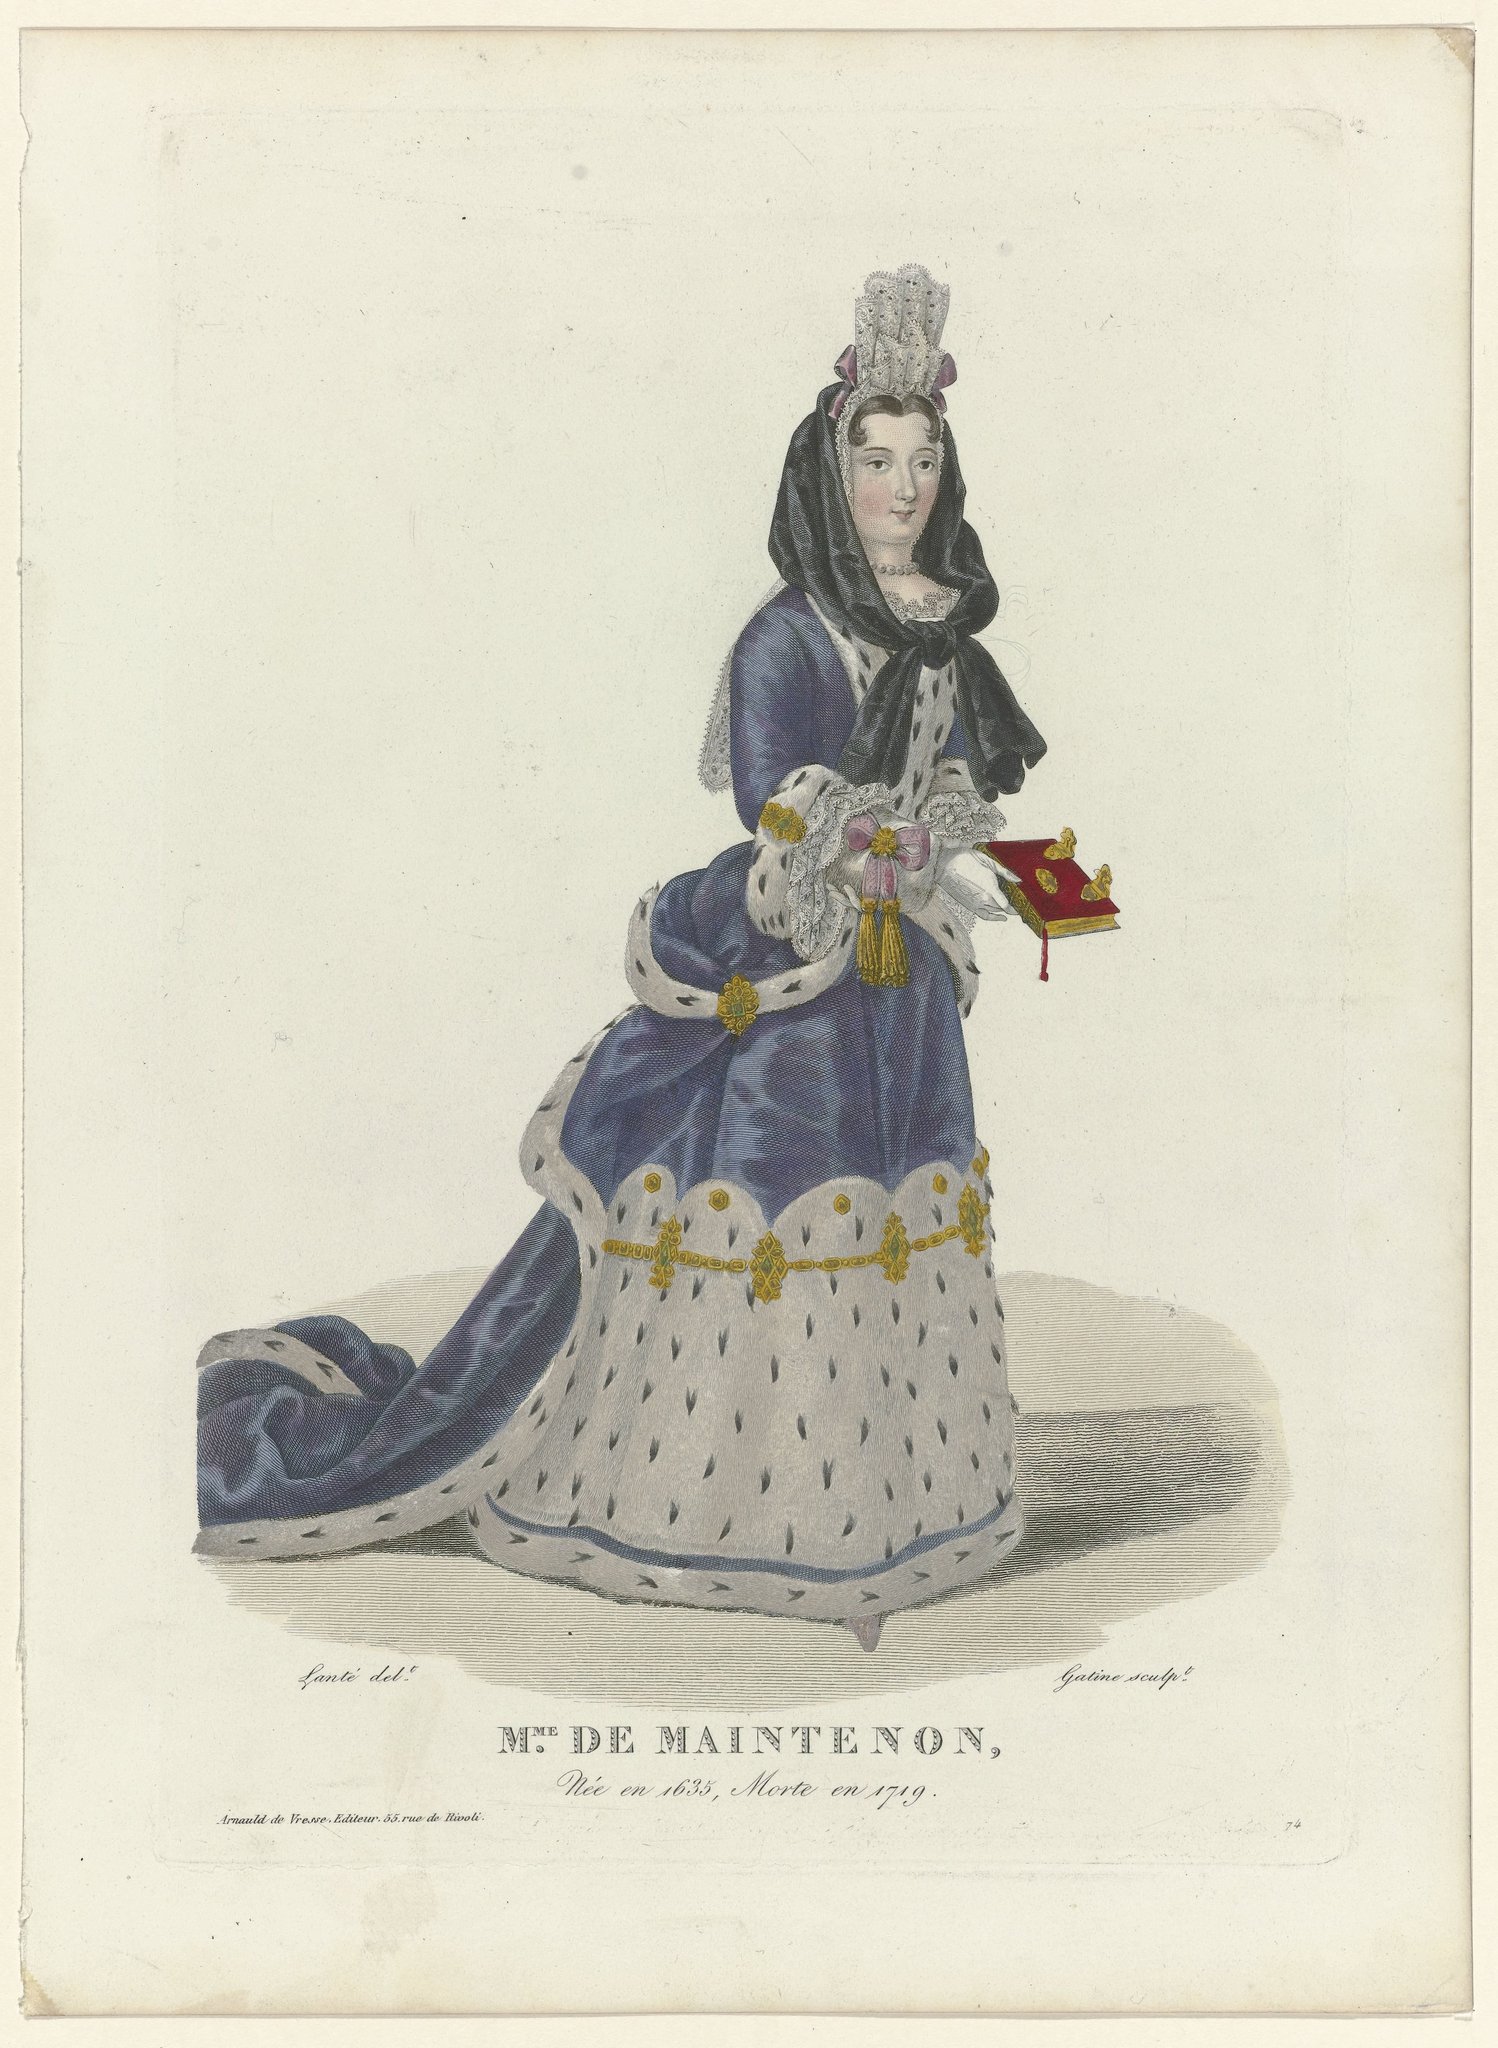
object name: costume print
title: Madame de Maintenon, Née en 1635, Morte en 1719, No. 74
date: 1783-1831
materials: paper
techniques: engraving, hand coloring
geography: paris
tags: madame de maintenon, bow (ornamental part of clothing) (+ women's clothes), ornamental parts of clothing (+ fur used for clothes), head-gear: hood (+ women's clothes), fashion plates, clothes, costume (+ women's clothes), skirt (+ women's clothes), gloves, mittens, etc. (+ women's clothes), book, head-gear: fontange (+ women's clothes), dress, gown: manteau (+ women's clothes), muff (+ fur used for clothes), muff (+ women's clothes)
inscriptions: title: ‘M.lle DE MAINTENON, Née en 1635, Morte en 1719.’, address: ‘Arnauld de Vresse, Editeur, 55, rue de Rivoli.’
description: Portret van Madame de Maintenon (1635-1719) Zij draagt een tweedelige japon of manteau met sleep versierd met marterbont en goudkleurige versieringen. Engageantes. Accessoires: fontange, geknoopte doek om het hoofd, collier, mof van bont versierd strik met aan de uiteinden kwasten, handschoen. Boek met sloten.